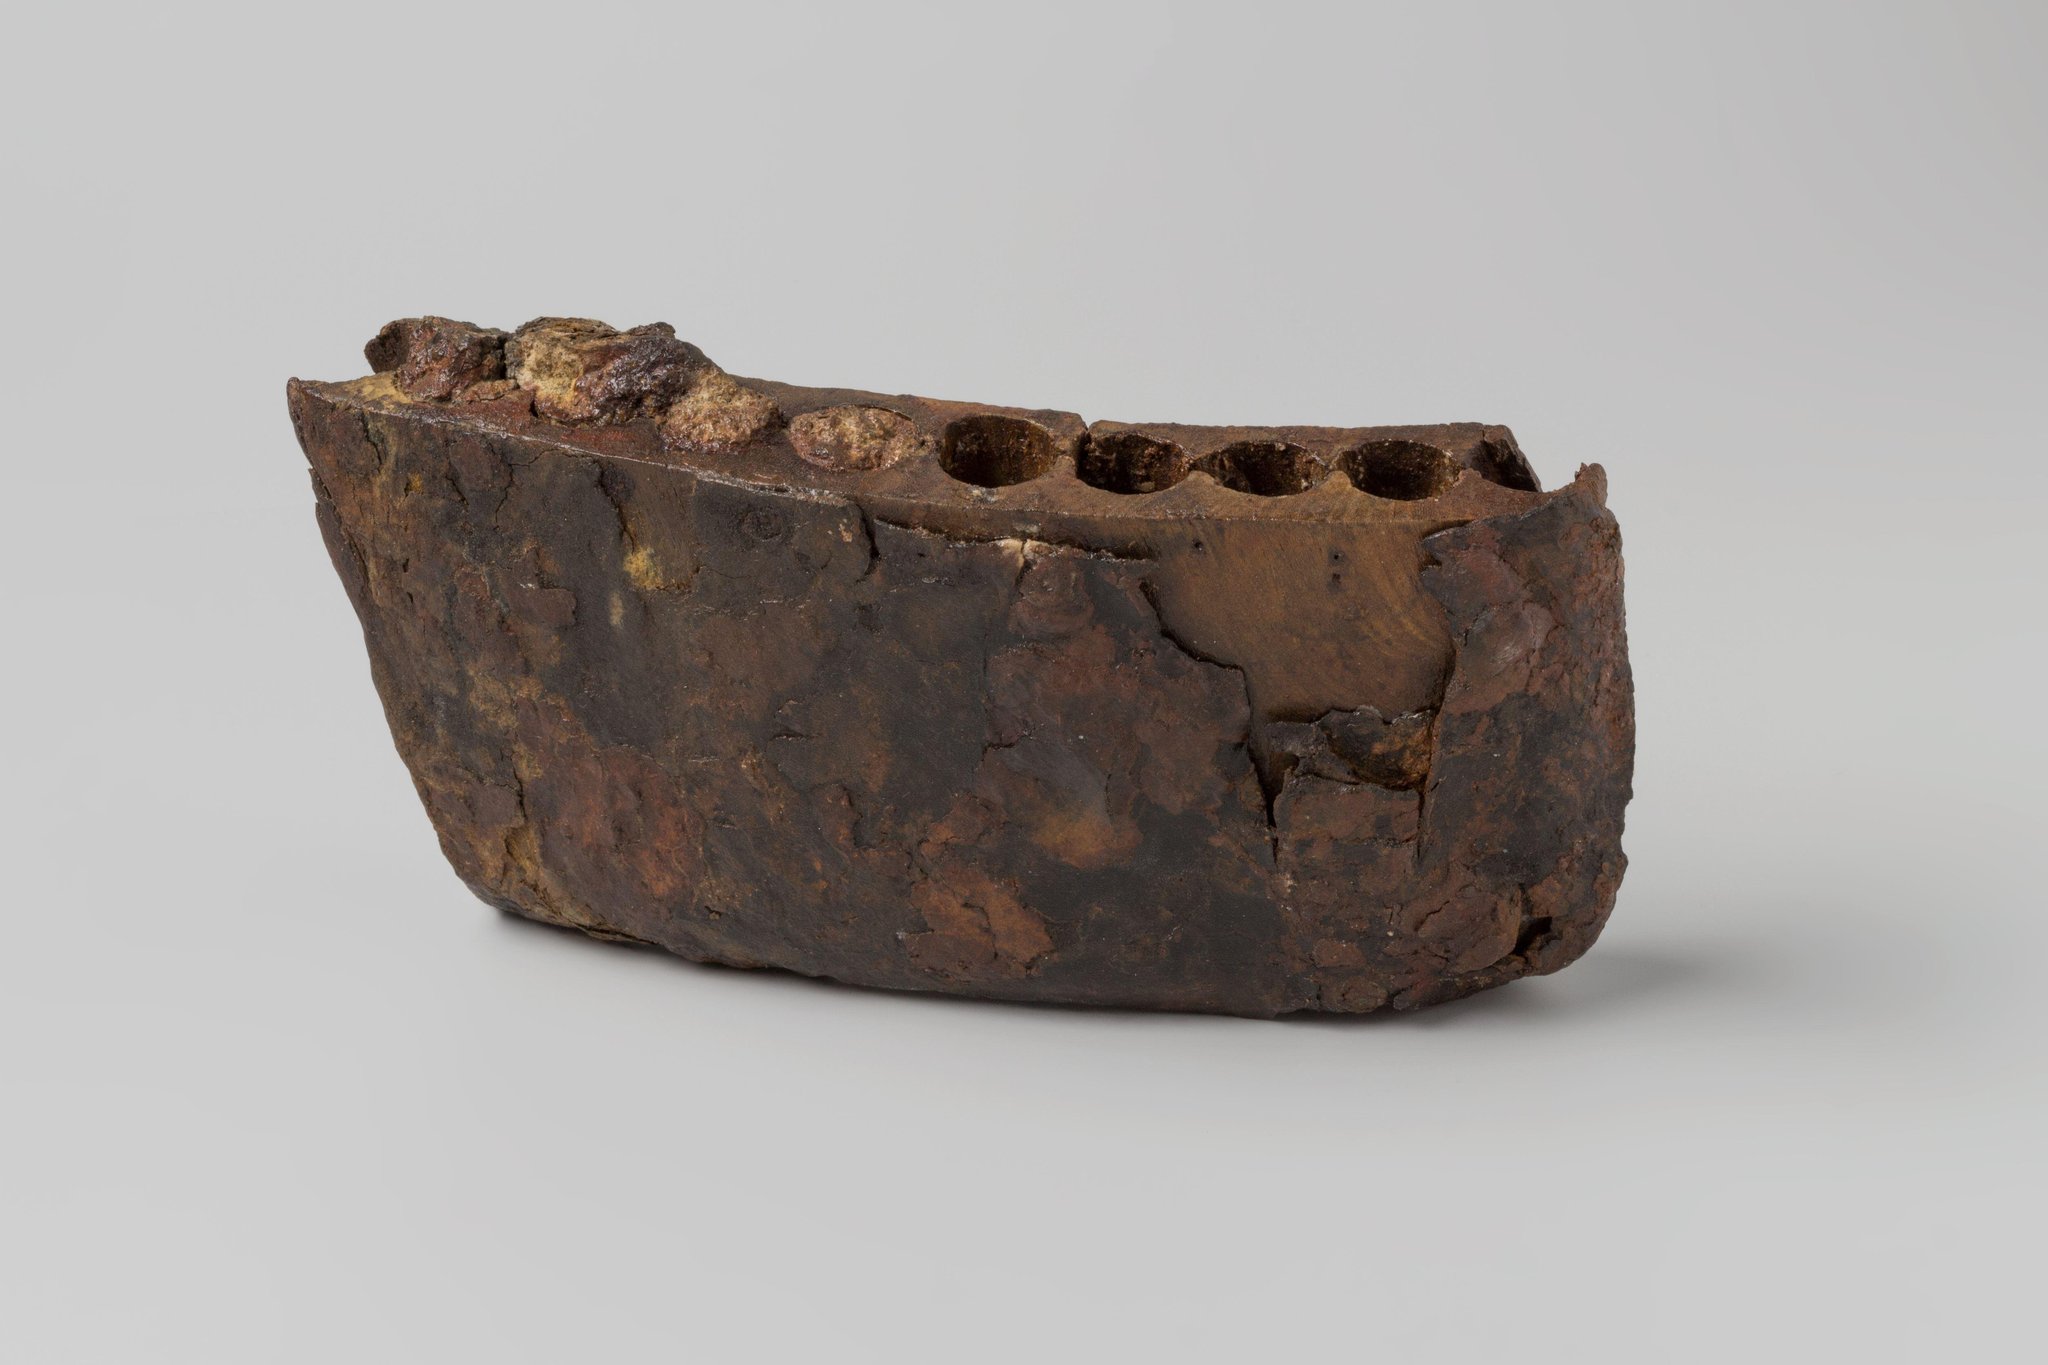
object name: cartridge pouch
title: Patroontas uit het wrak van de Oost-Indiëvaarder Hollandia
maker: Anonymous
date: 1700-1743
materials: leather, wood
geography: netherlands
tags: verenigde oostindische compagnie, hollandia (schip), annet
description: Cartridge case; fragm of flat curved box, rounded side, other side broken off, rounded base, flat open top, inside 10 vertical circular drilled tubes, fragm of leather cover.